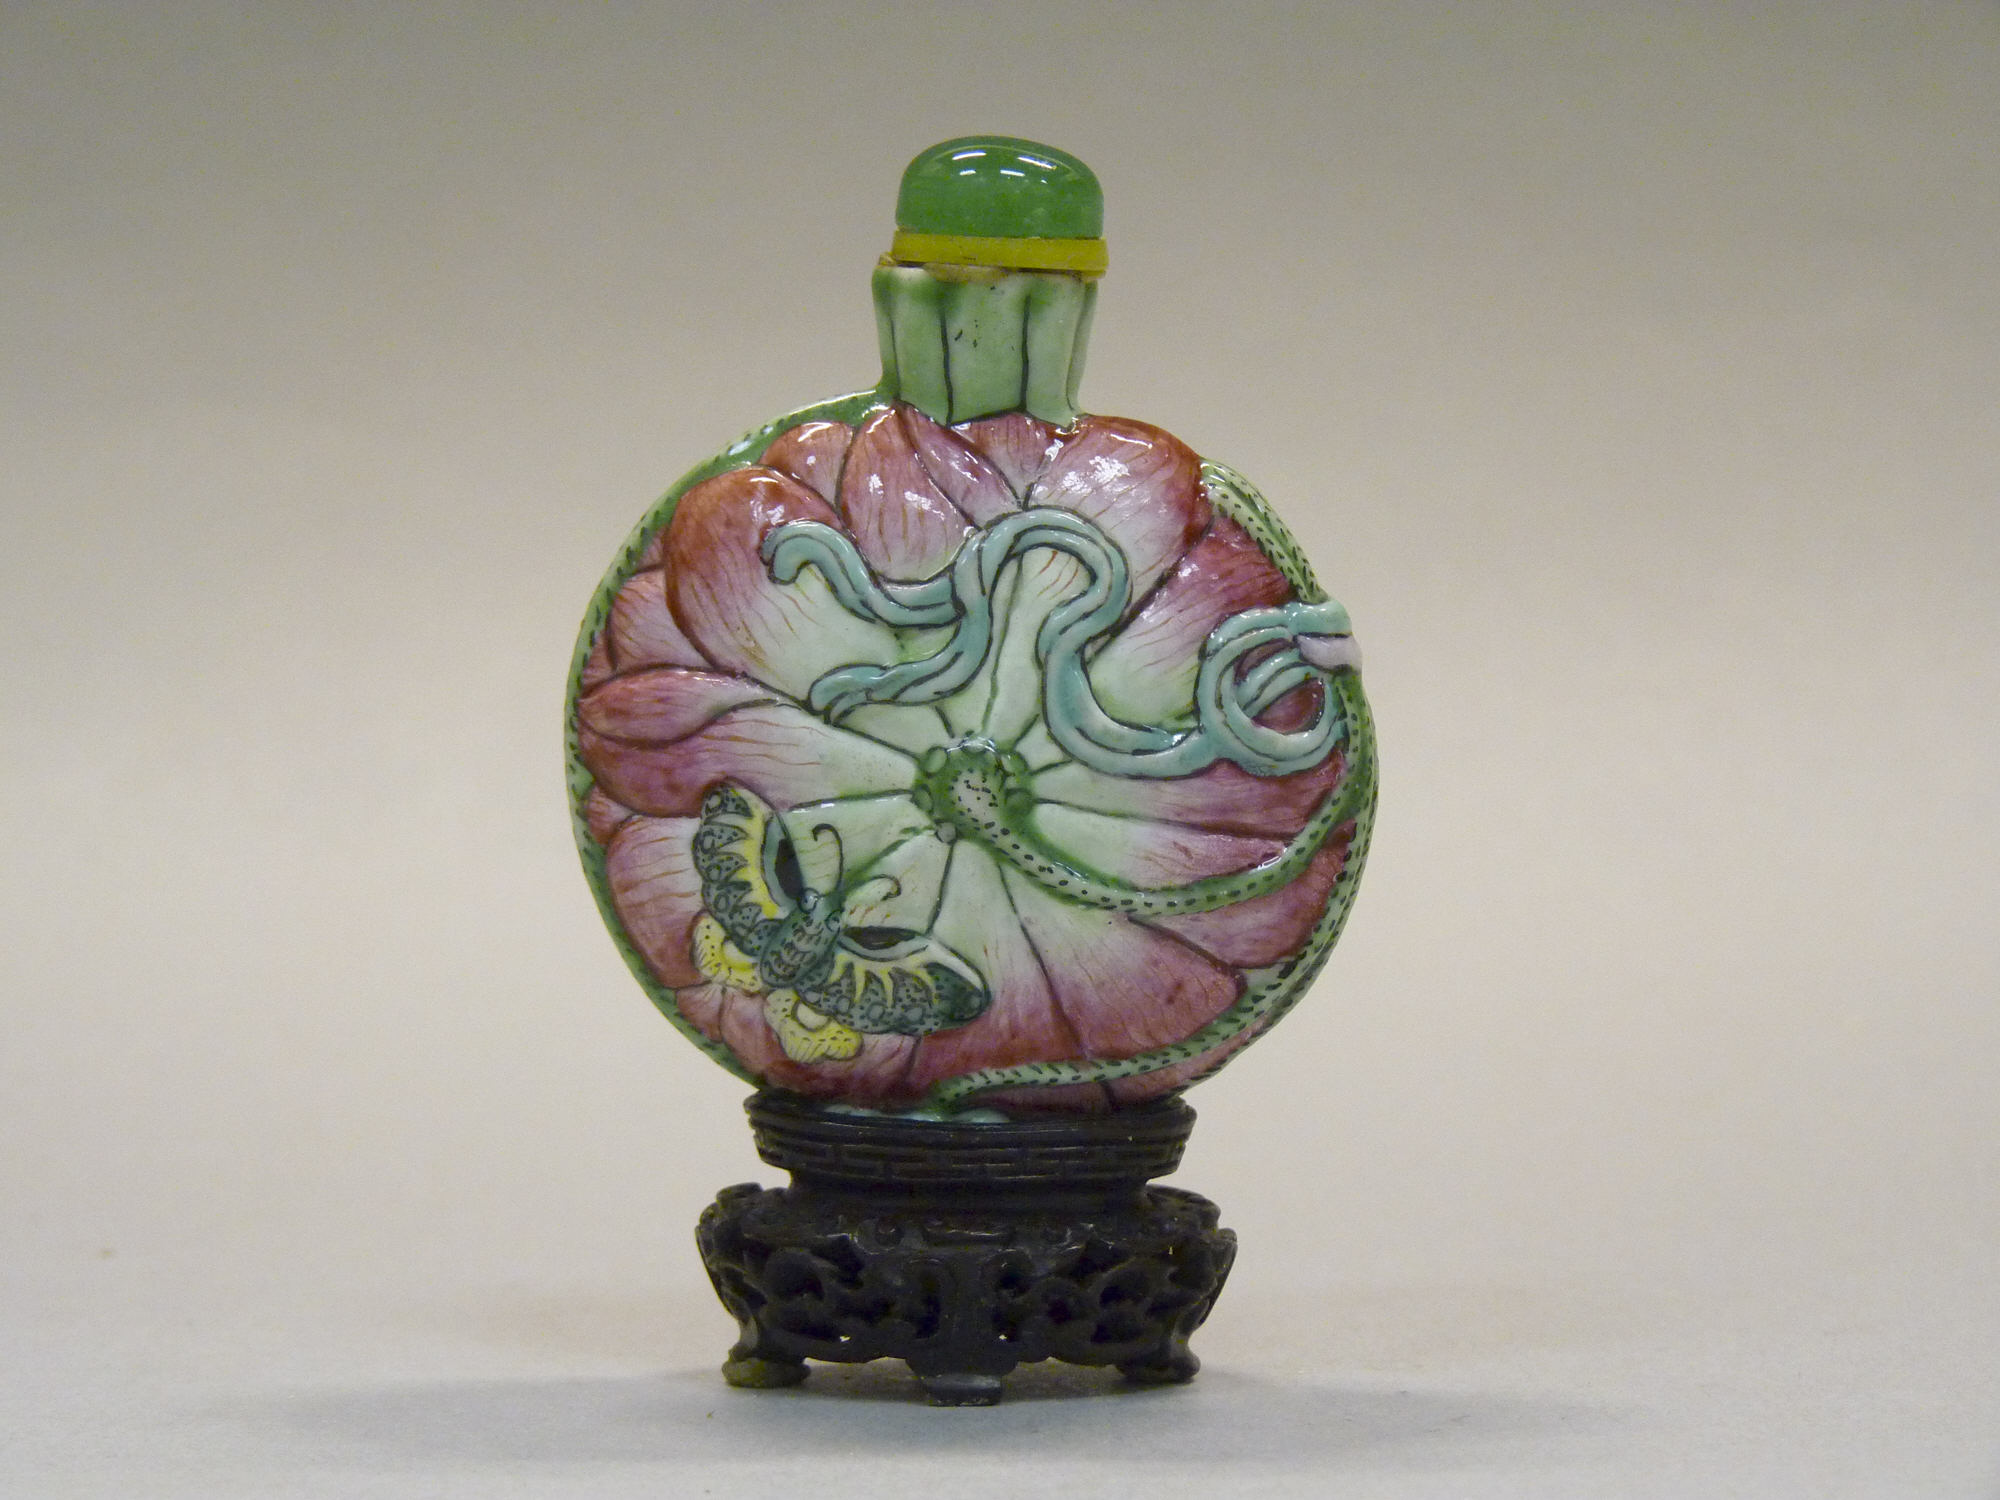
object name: snuff bottle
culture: chinese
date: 1801-1900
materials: glass, porcelain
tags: butterflies,flowers